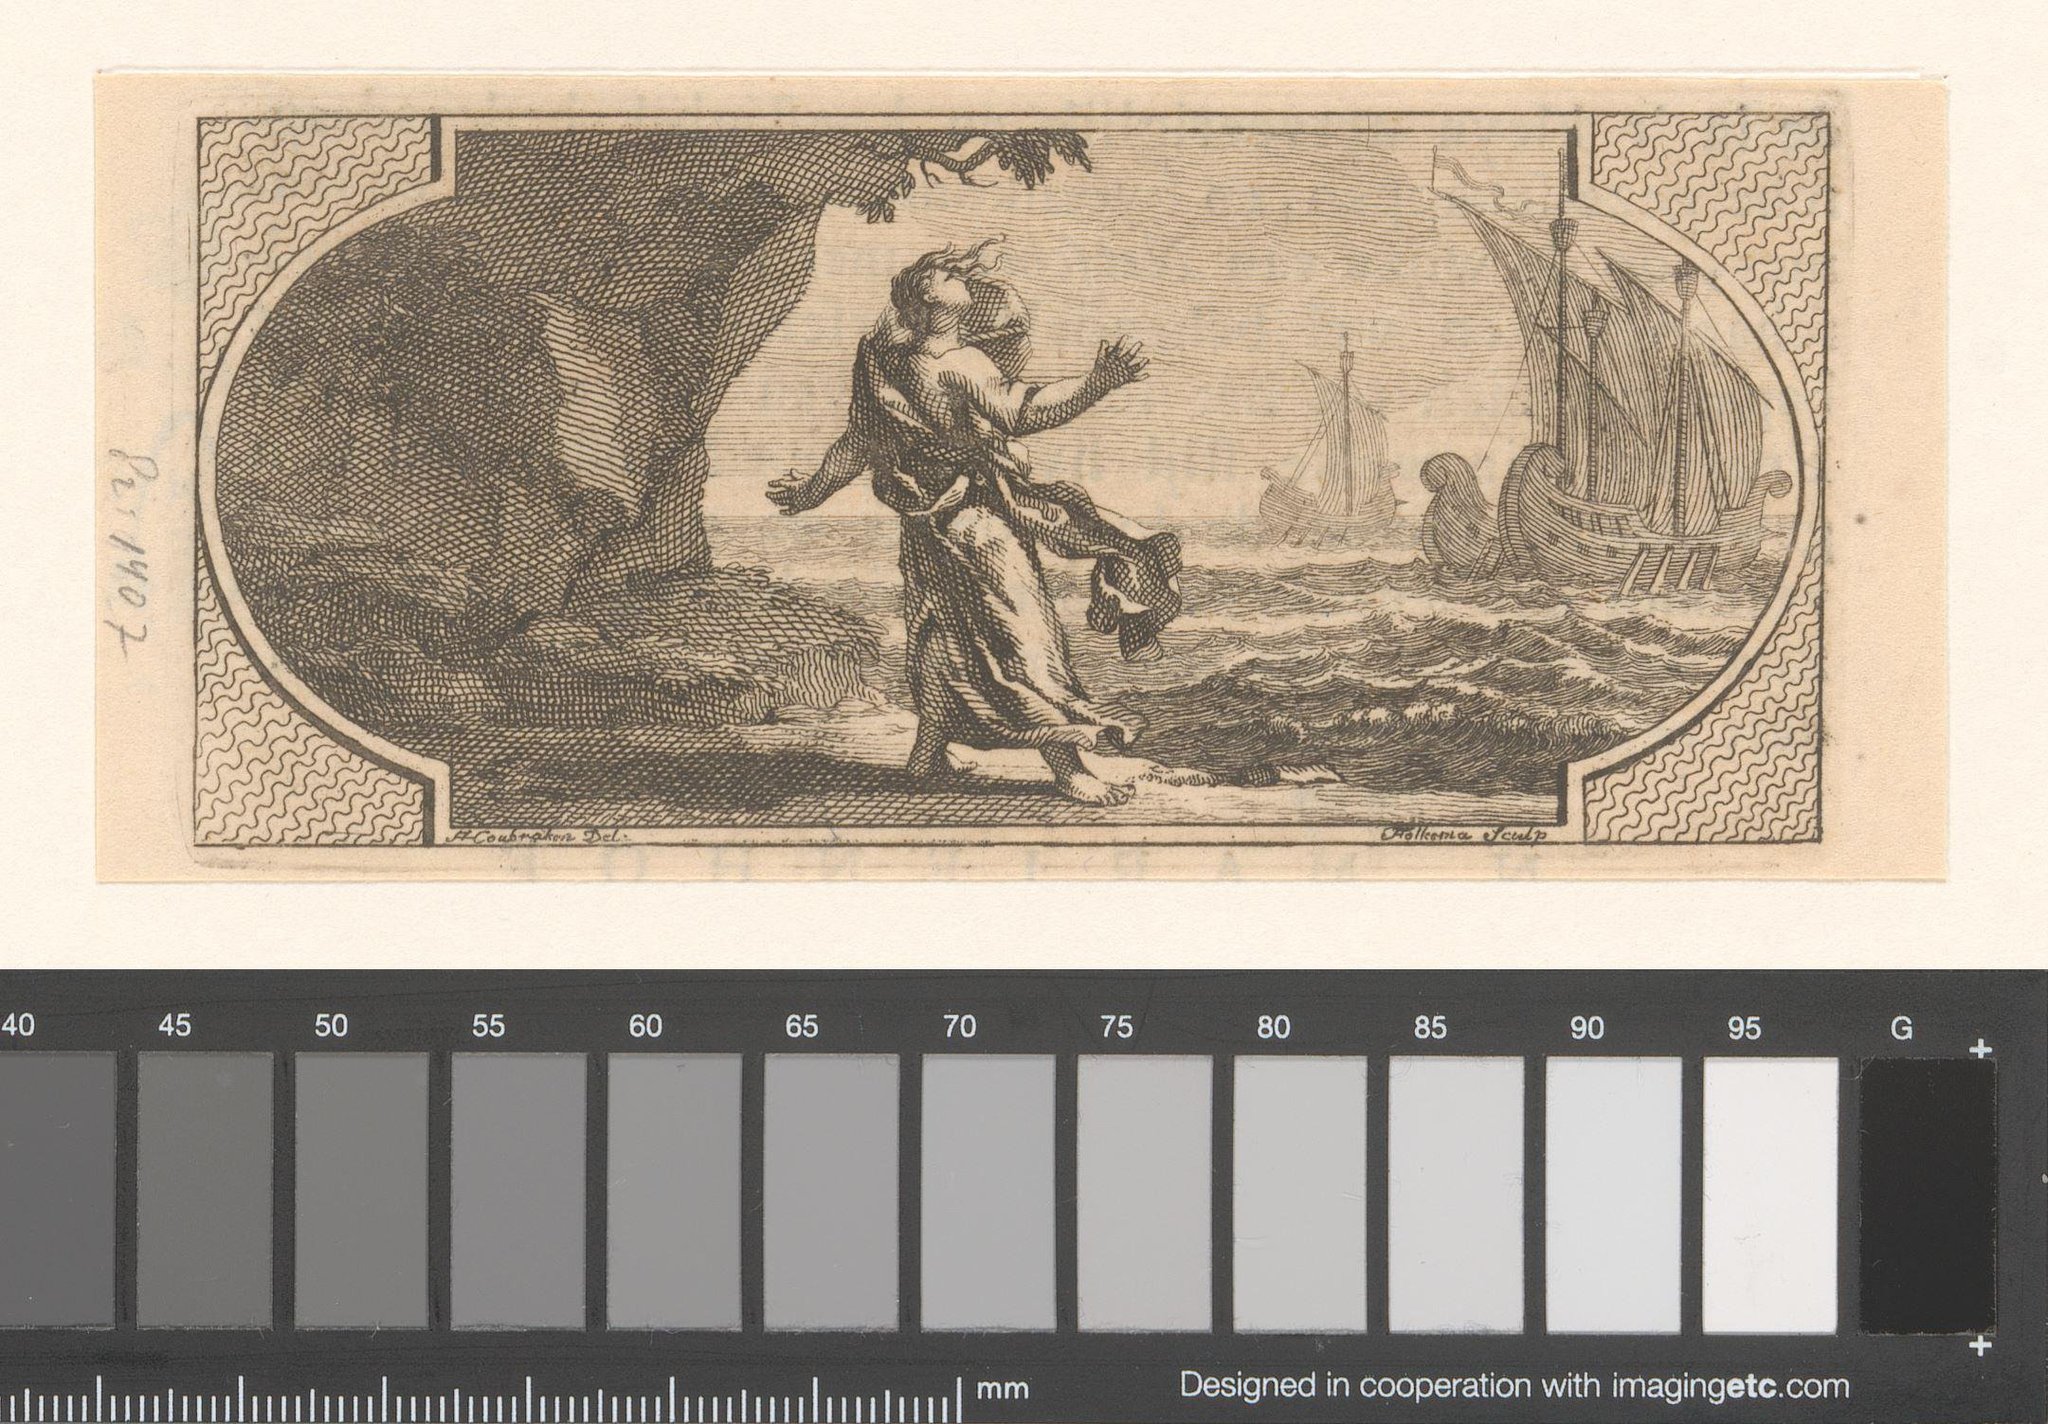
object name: print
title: Circe kijkt naar schepen vanaf haar eiland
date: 1729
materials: paper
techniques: etching, letterpress printing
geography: the hague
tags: circe, vignette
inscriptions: collector's mark: Lugt 2760, collector's mark: Lugt 2228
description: Prent uit: Weyerman, Jacob Campo. De levens-beschryvingen der Nederlandsche konst-schilders en konst-schilderessen (...). Den Haag: Wed. E. Boucquet et al., 1729, dl. 3, p. 136. Deze prent is in verschillende drukken van dit werk uit 1729 op verschillende plekken in het boek gebruikt.